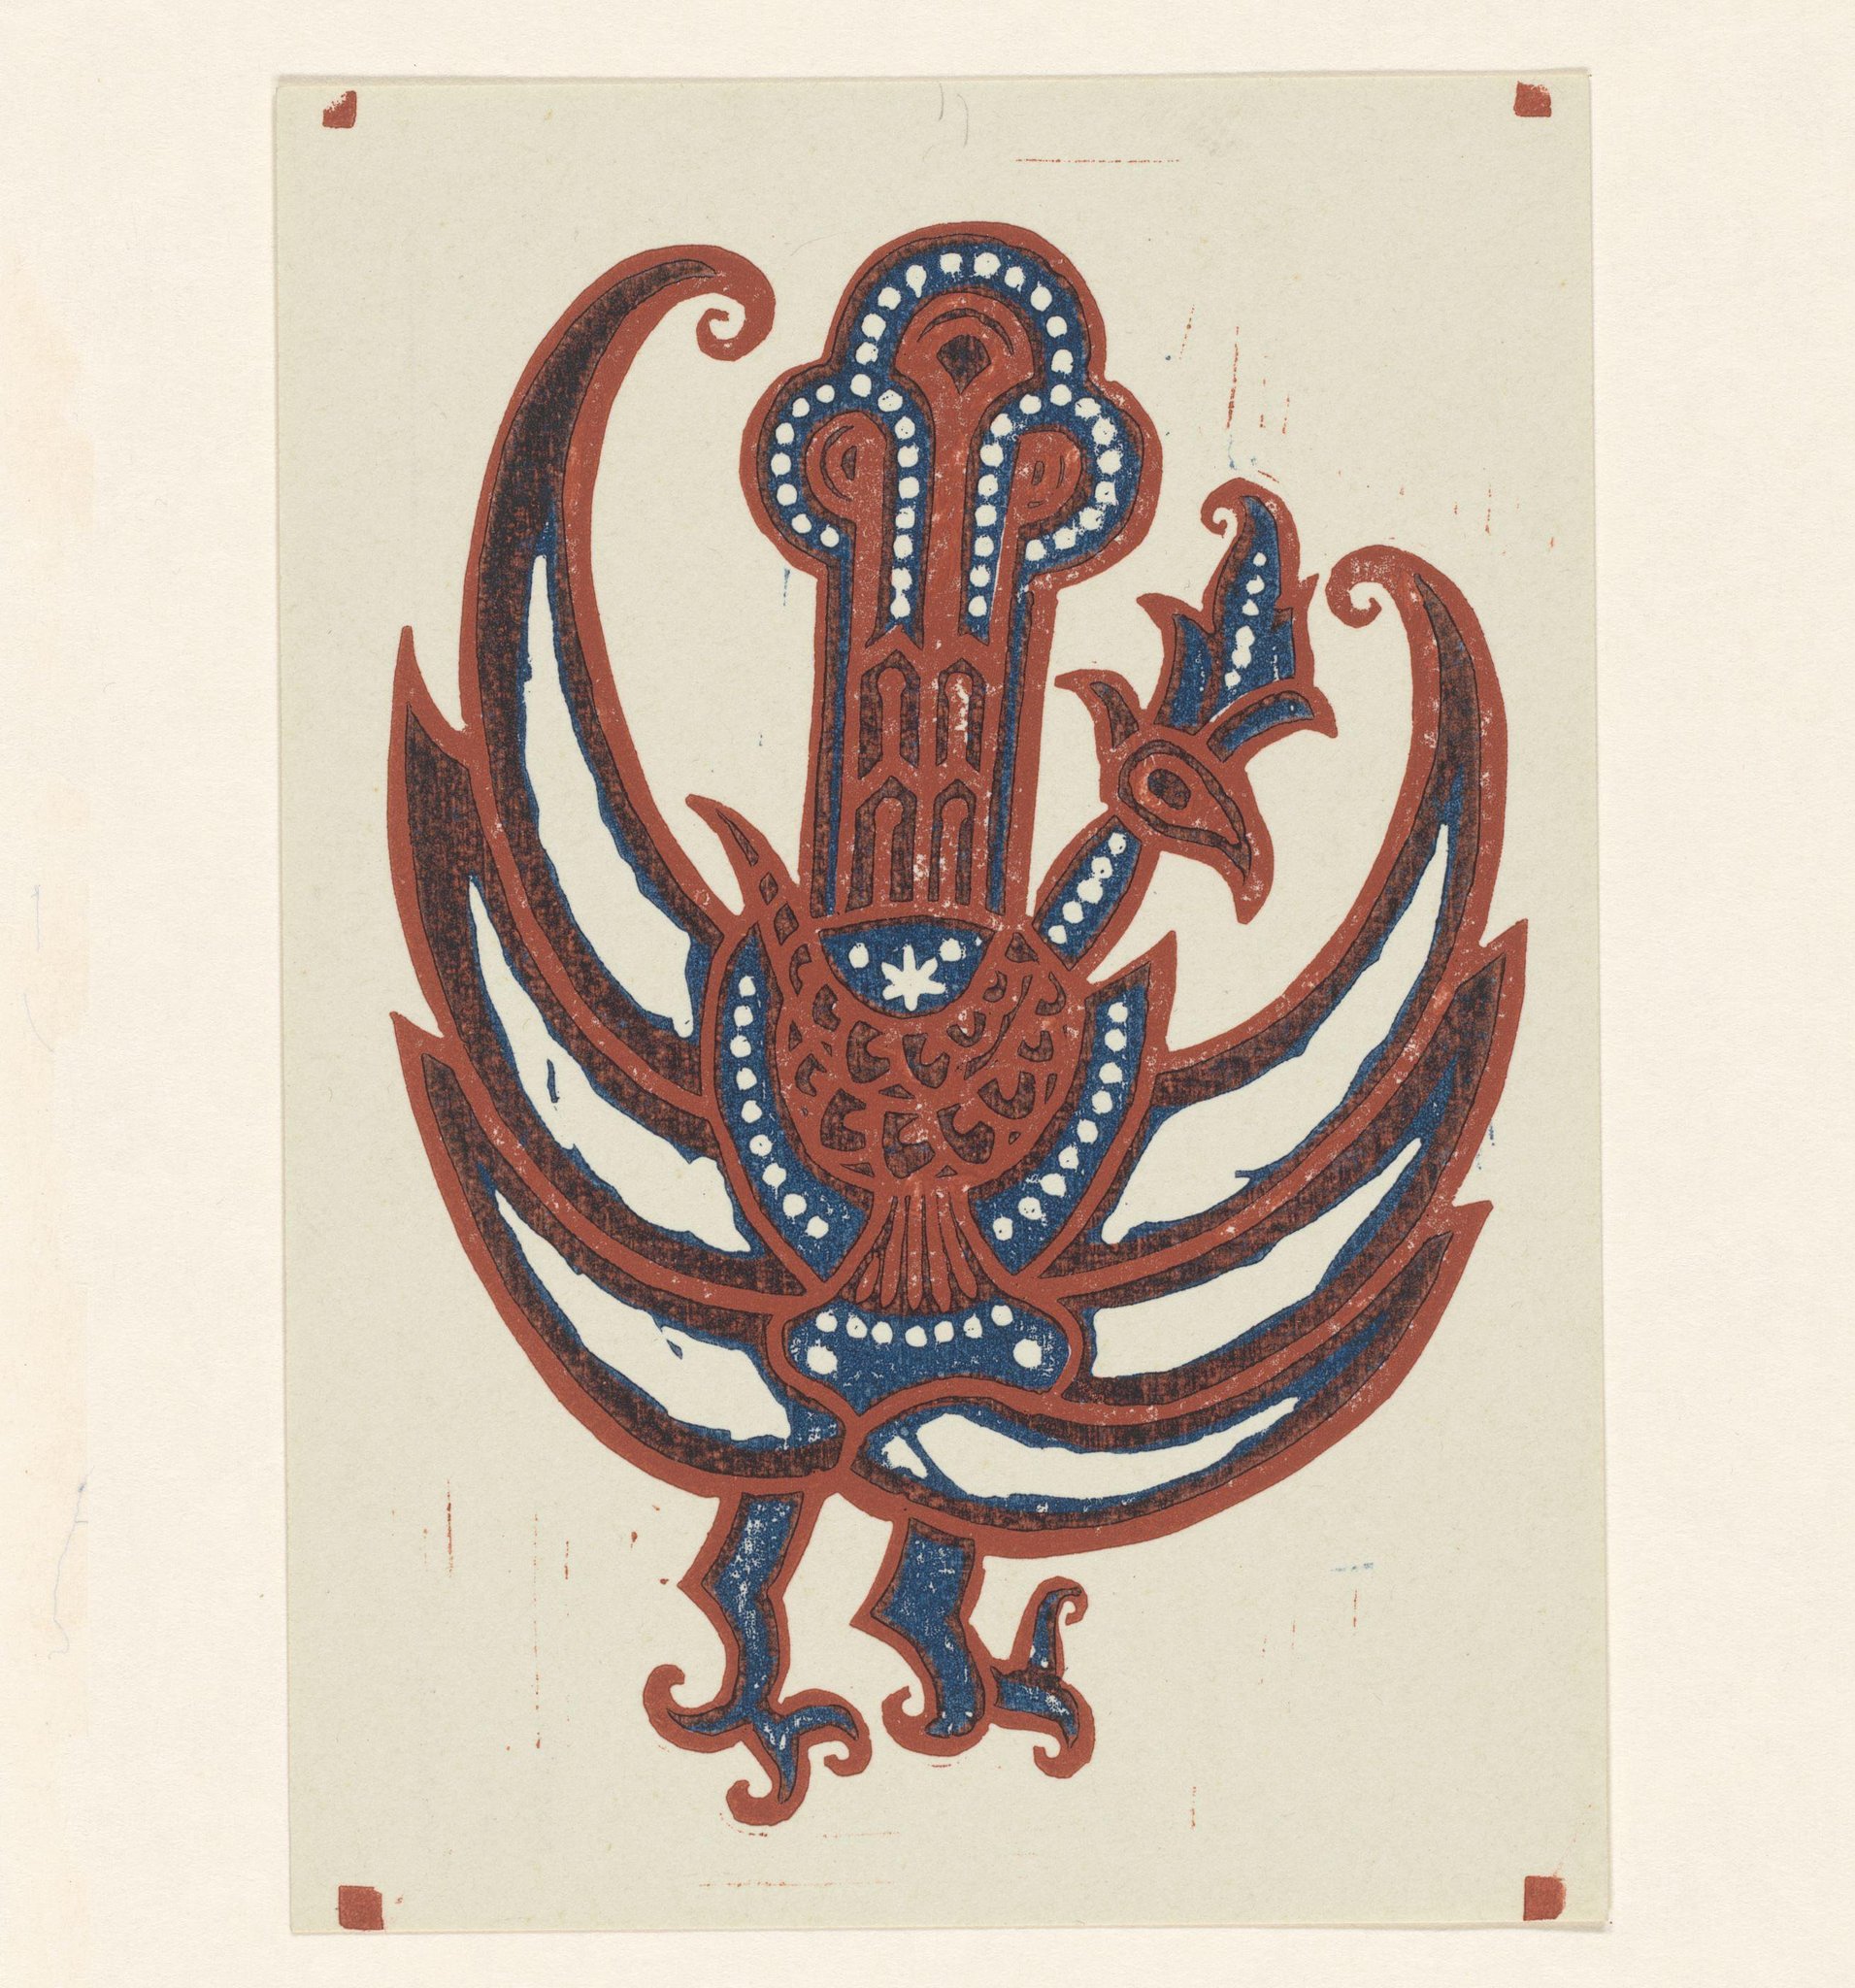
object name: postcard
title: Vogel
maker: reijer stolk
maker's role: draughtsman, print maker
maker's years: 1896-1945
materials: paper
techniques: woodcut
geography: netherlands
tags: fabulous animals ~ ornamental birds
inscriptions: collector's mark: Lugt 2228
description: Prent gebruikt voor: Reijer Stolk, Tien bladen sierkunst uit ons Oost-Indië, 1942.